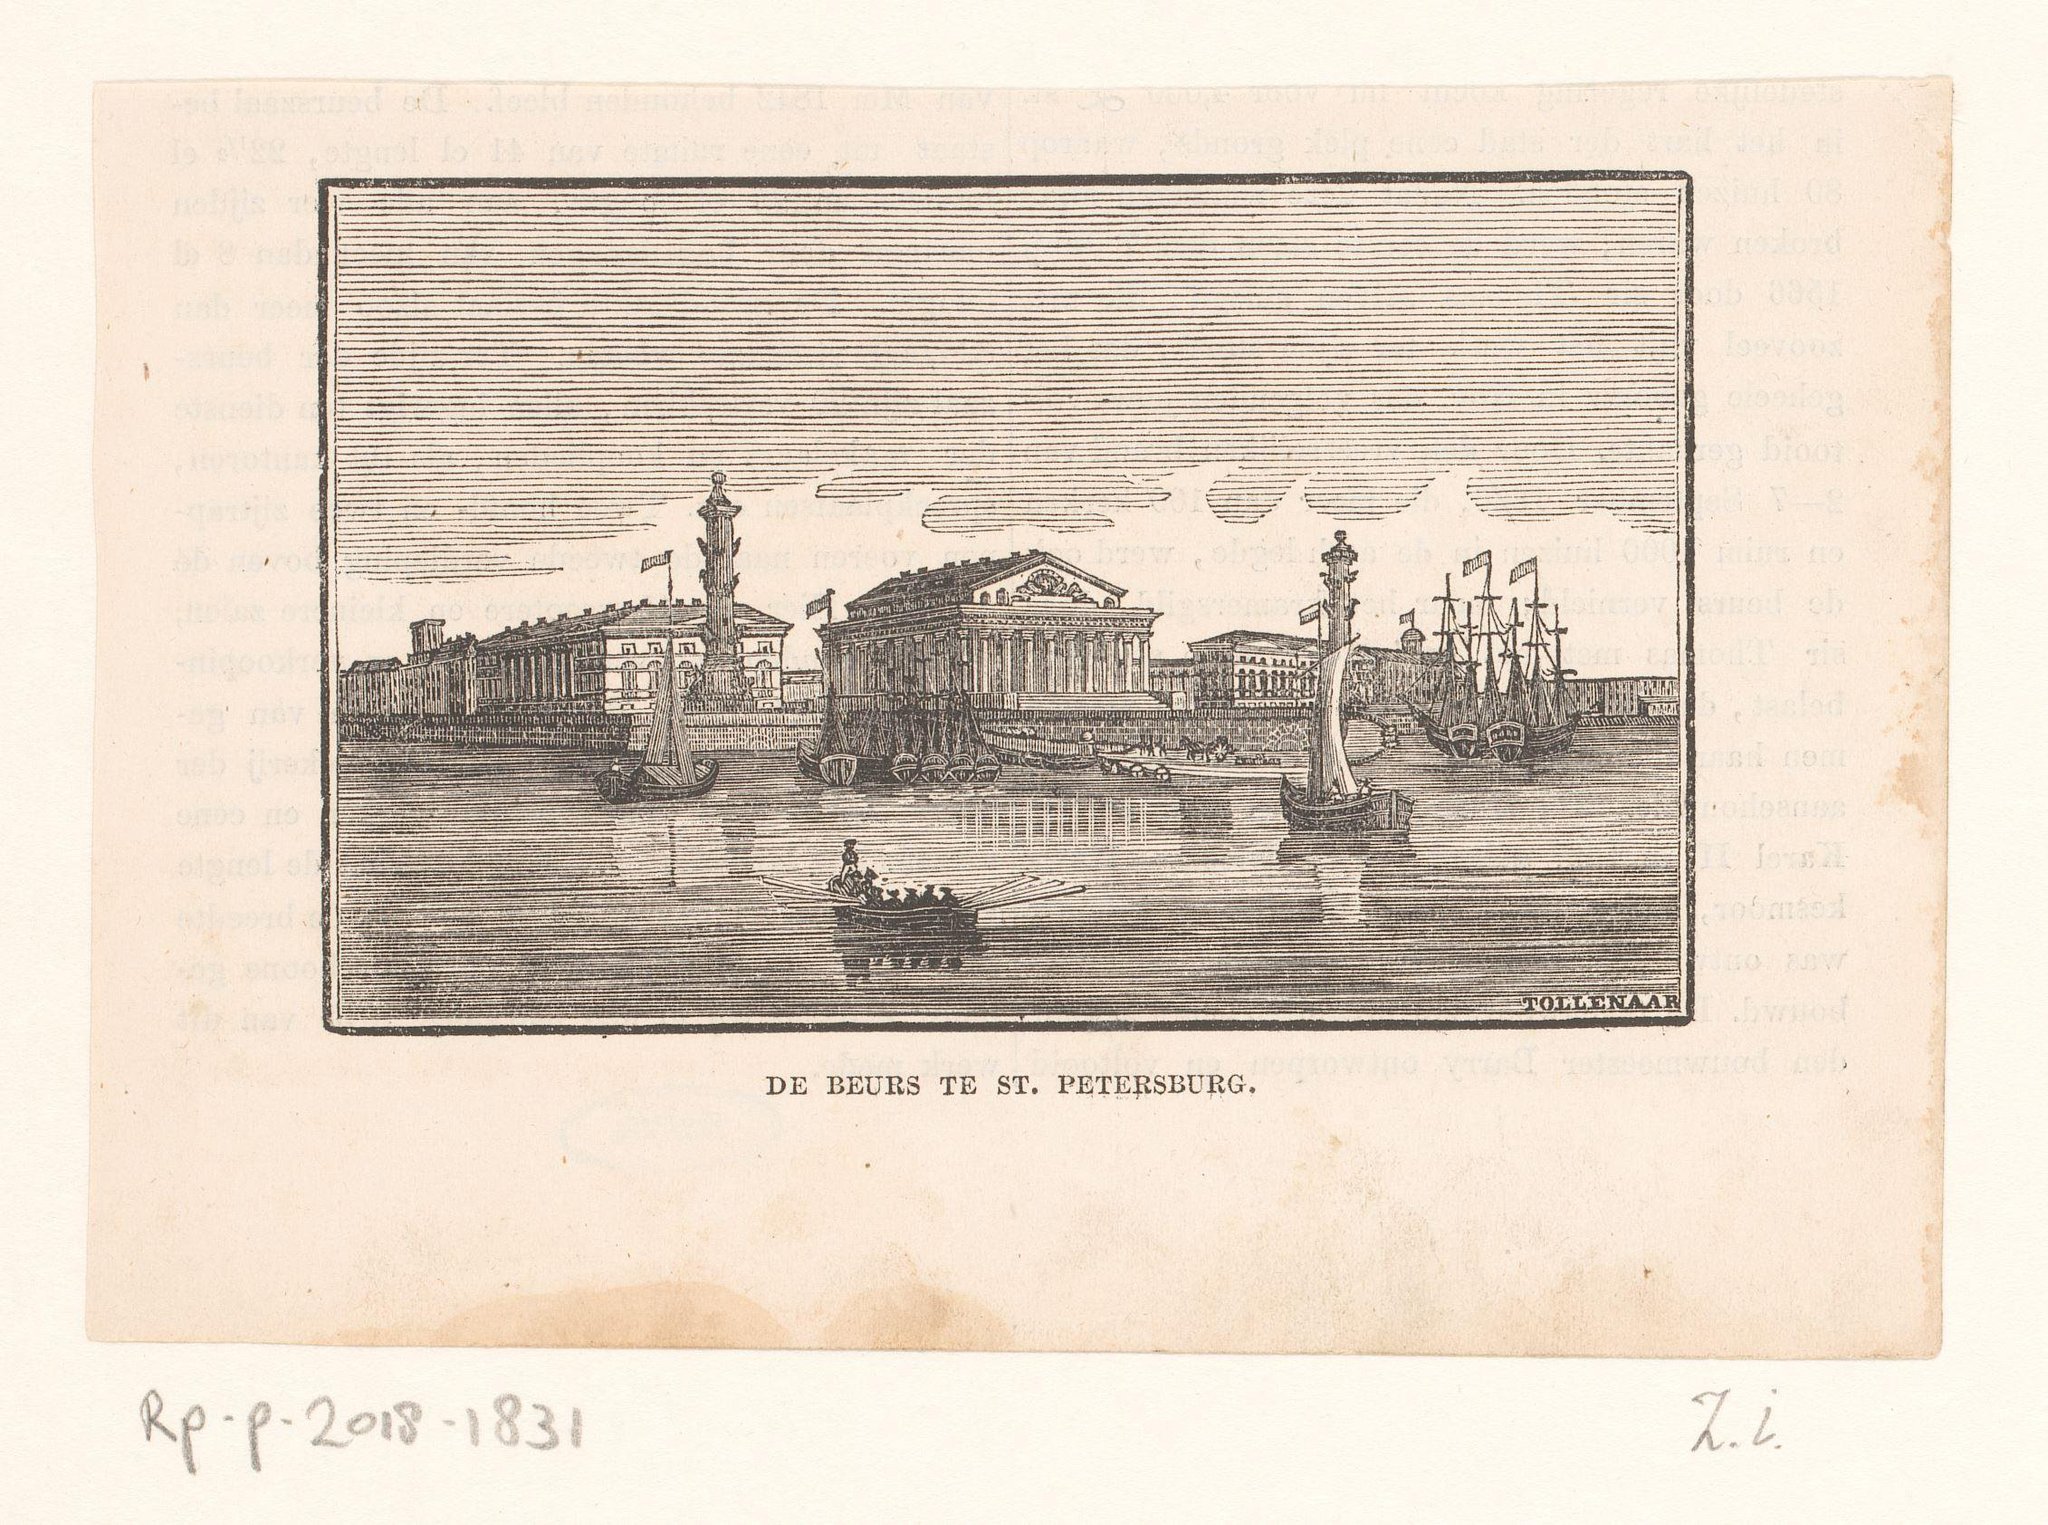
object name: book illustration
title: Gezicht op de beurs, te Sint-Petersburg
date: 1847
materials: paper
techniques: letterpress printing, engraving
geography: amsterdam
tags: exchange, bourse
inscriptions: collector's mark: Lugt 2228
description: Prent gebruikt in: Witkamp, P.H. Beschrijving van Oost- en Noord-Europa. Amsterdam: J.H. Laarman, 1847.